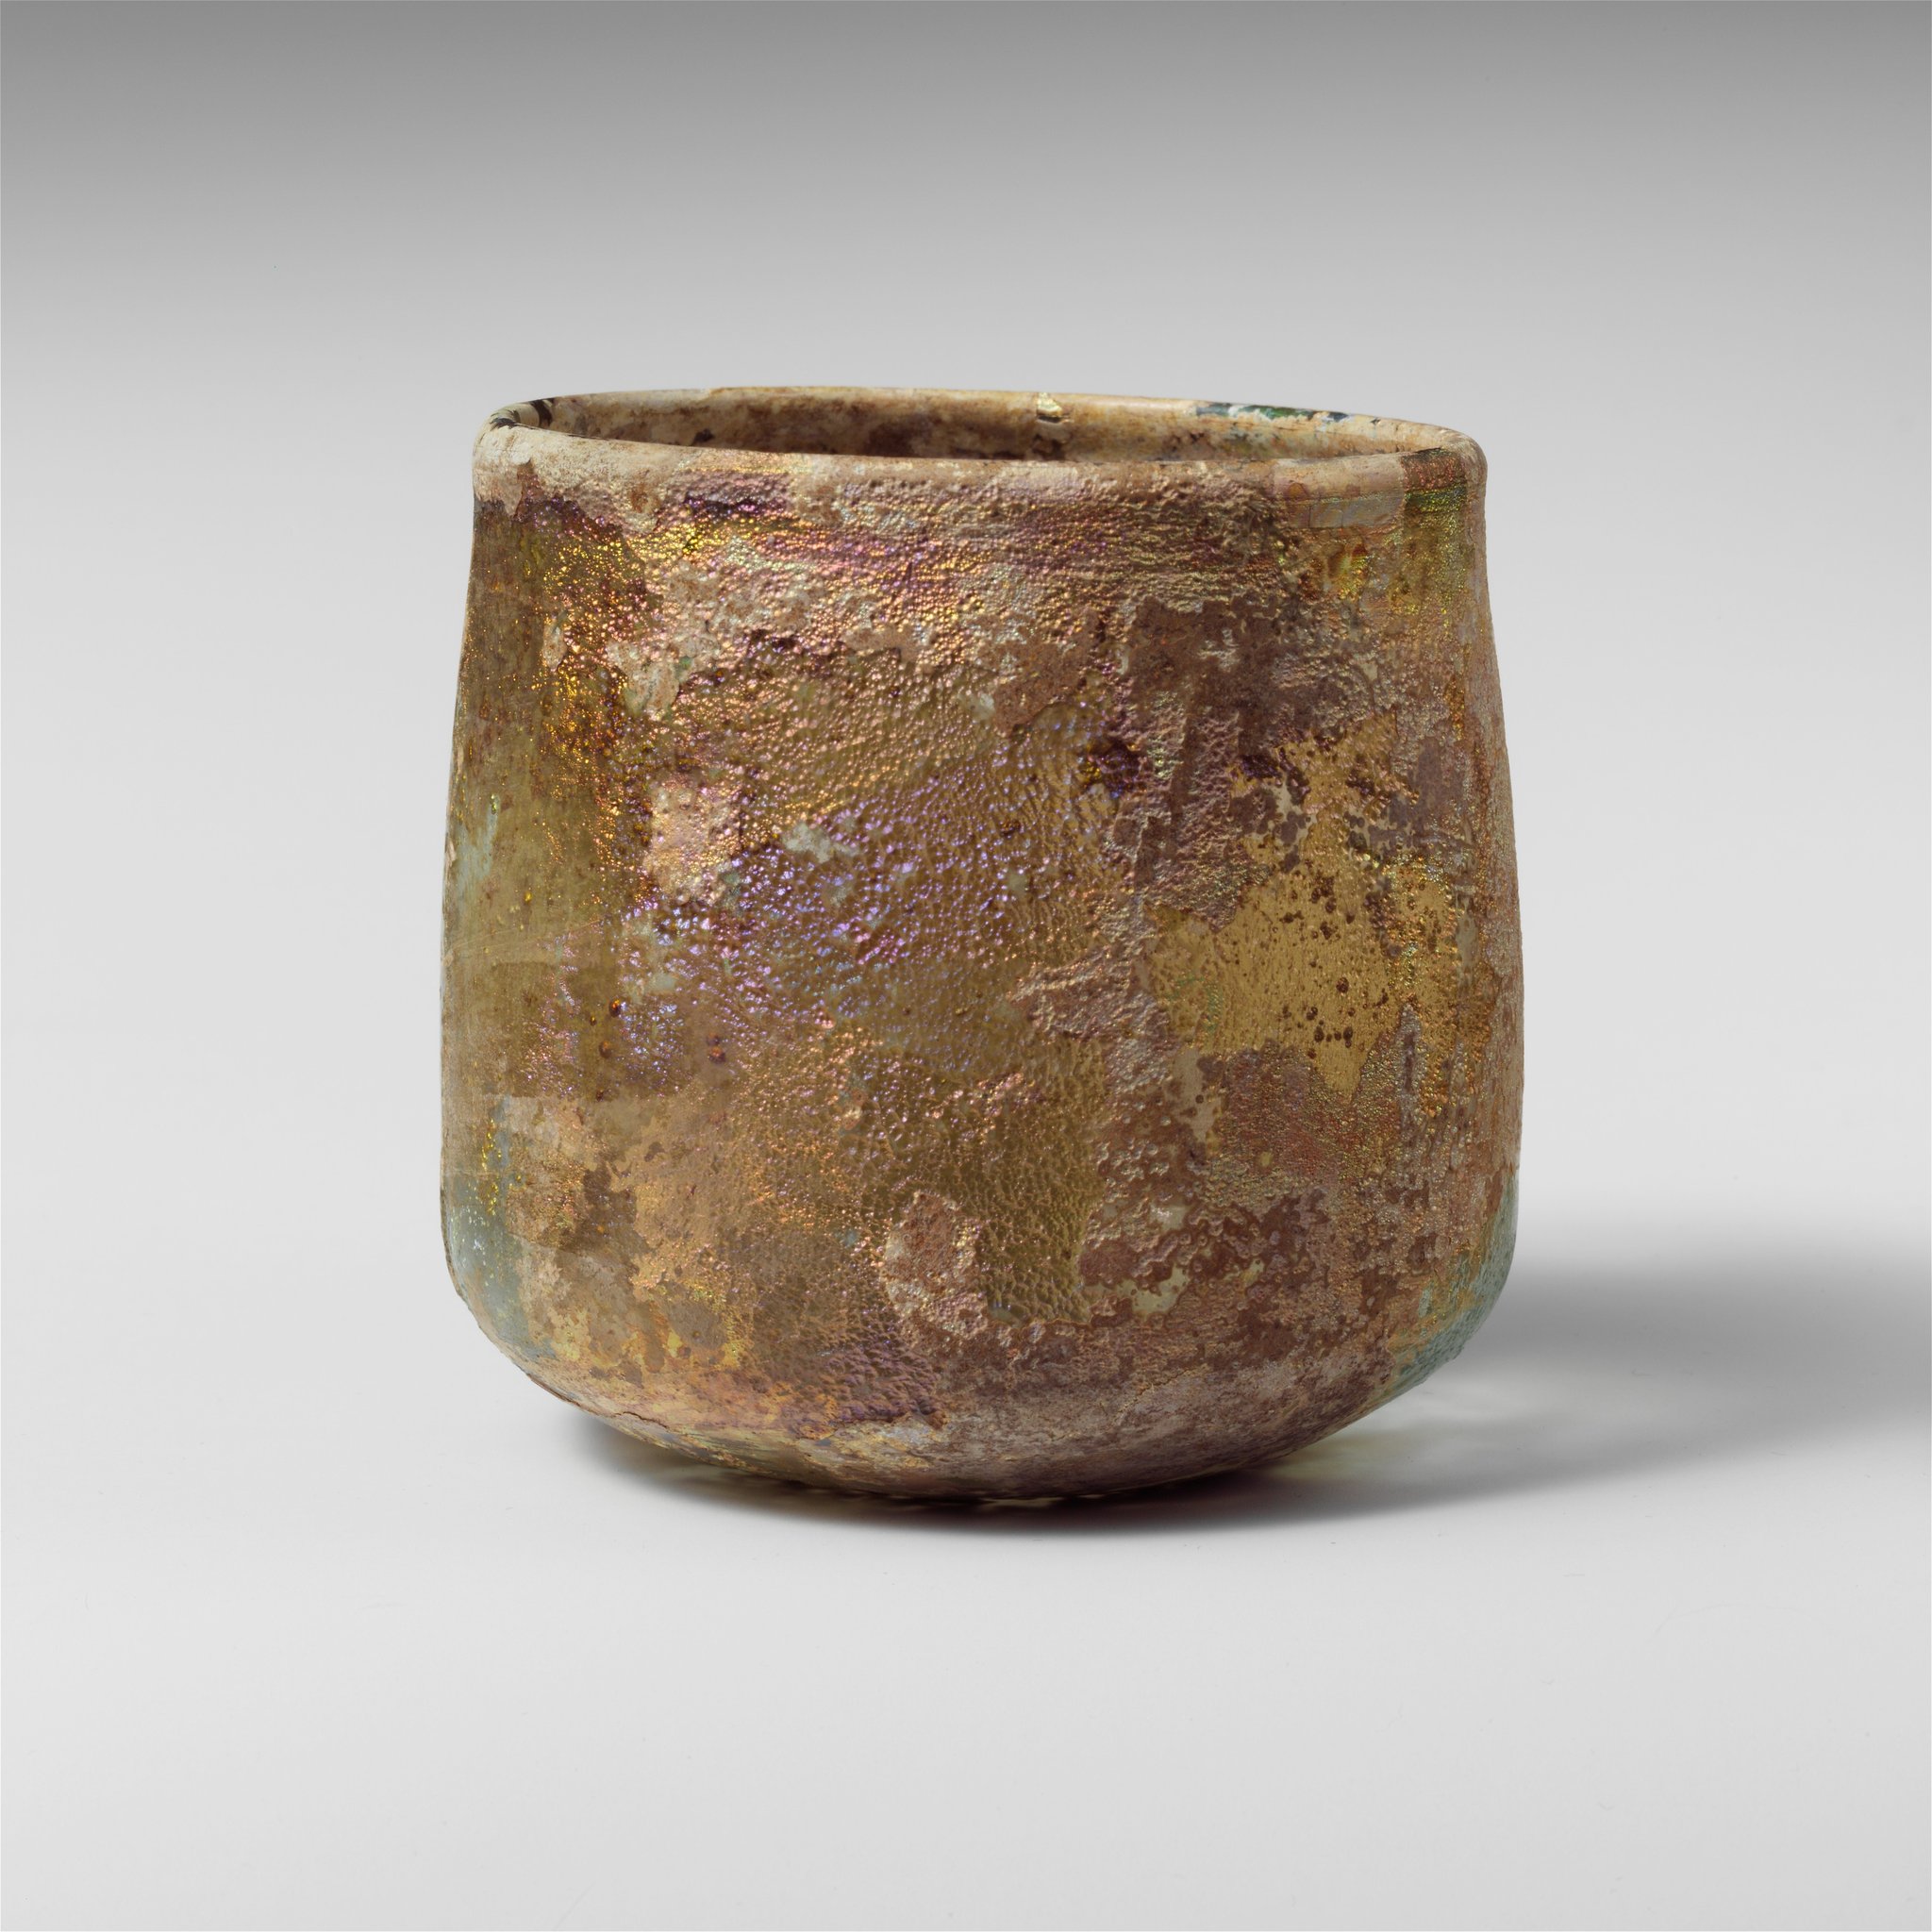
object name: cup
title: Glass beaker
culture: roman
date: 101-300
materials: glass